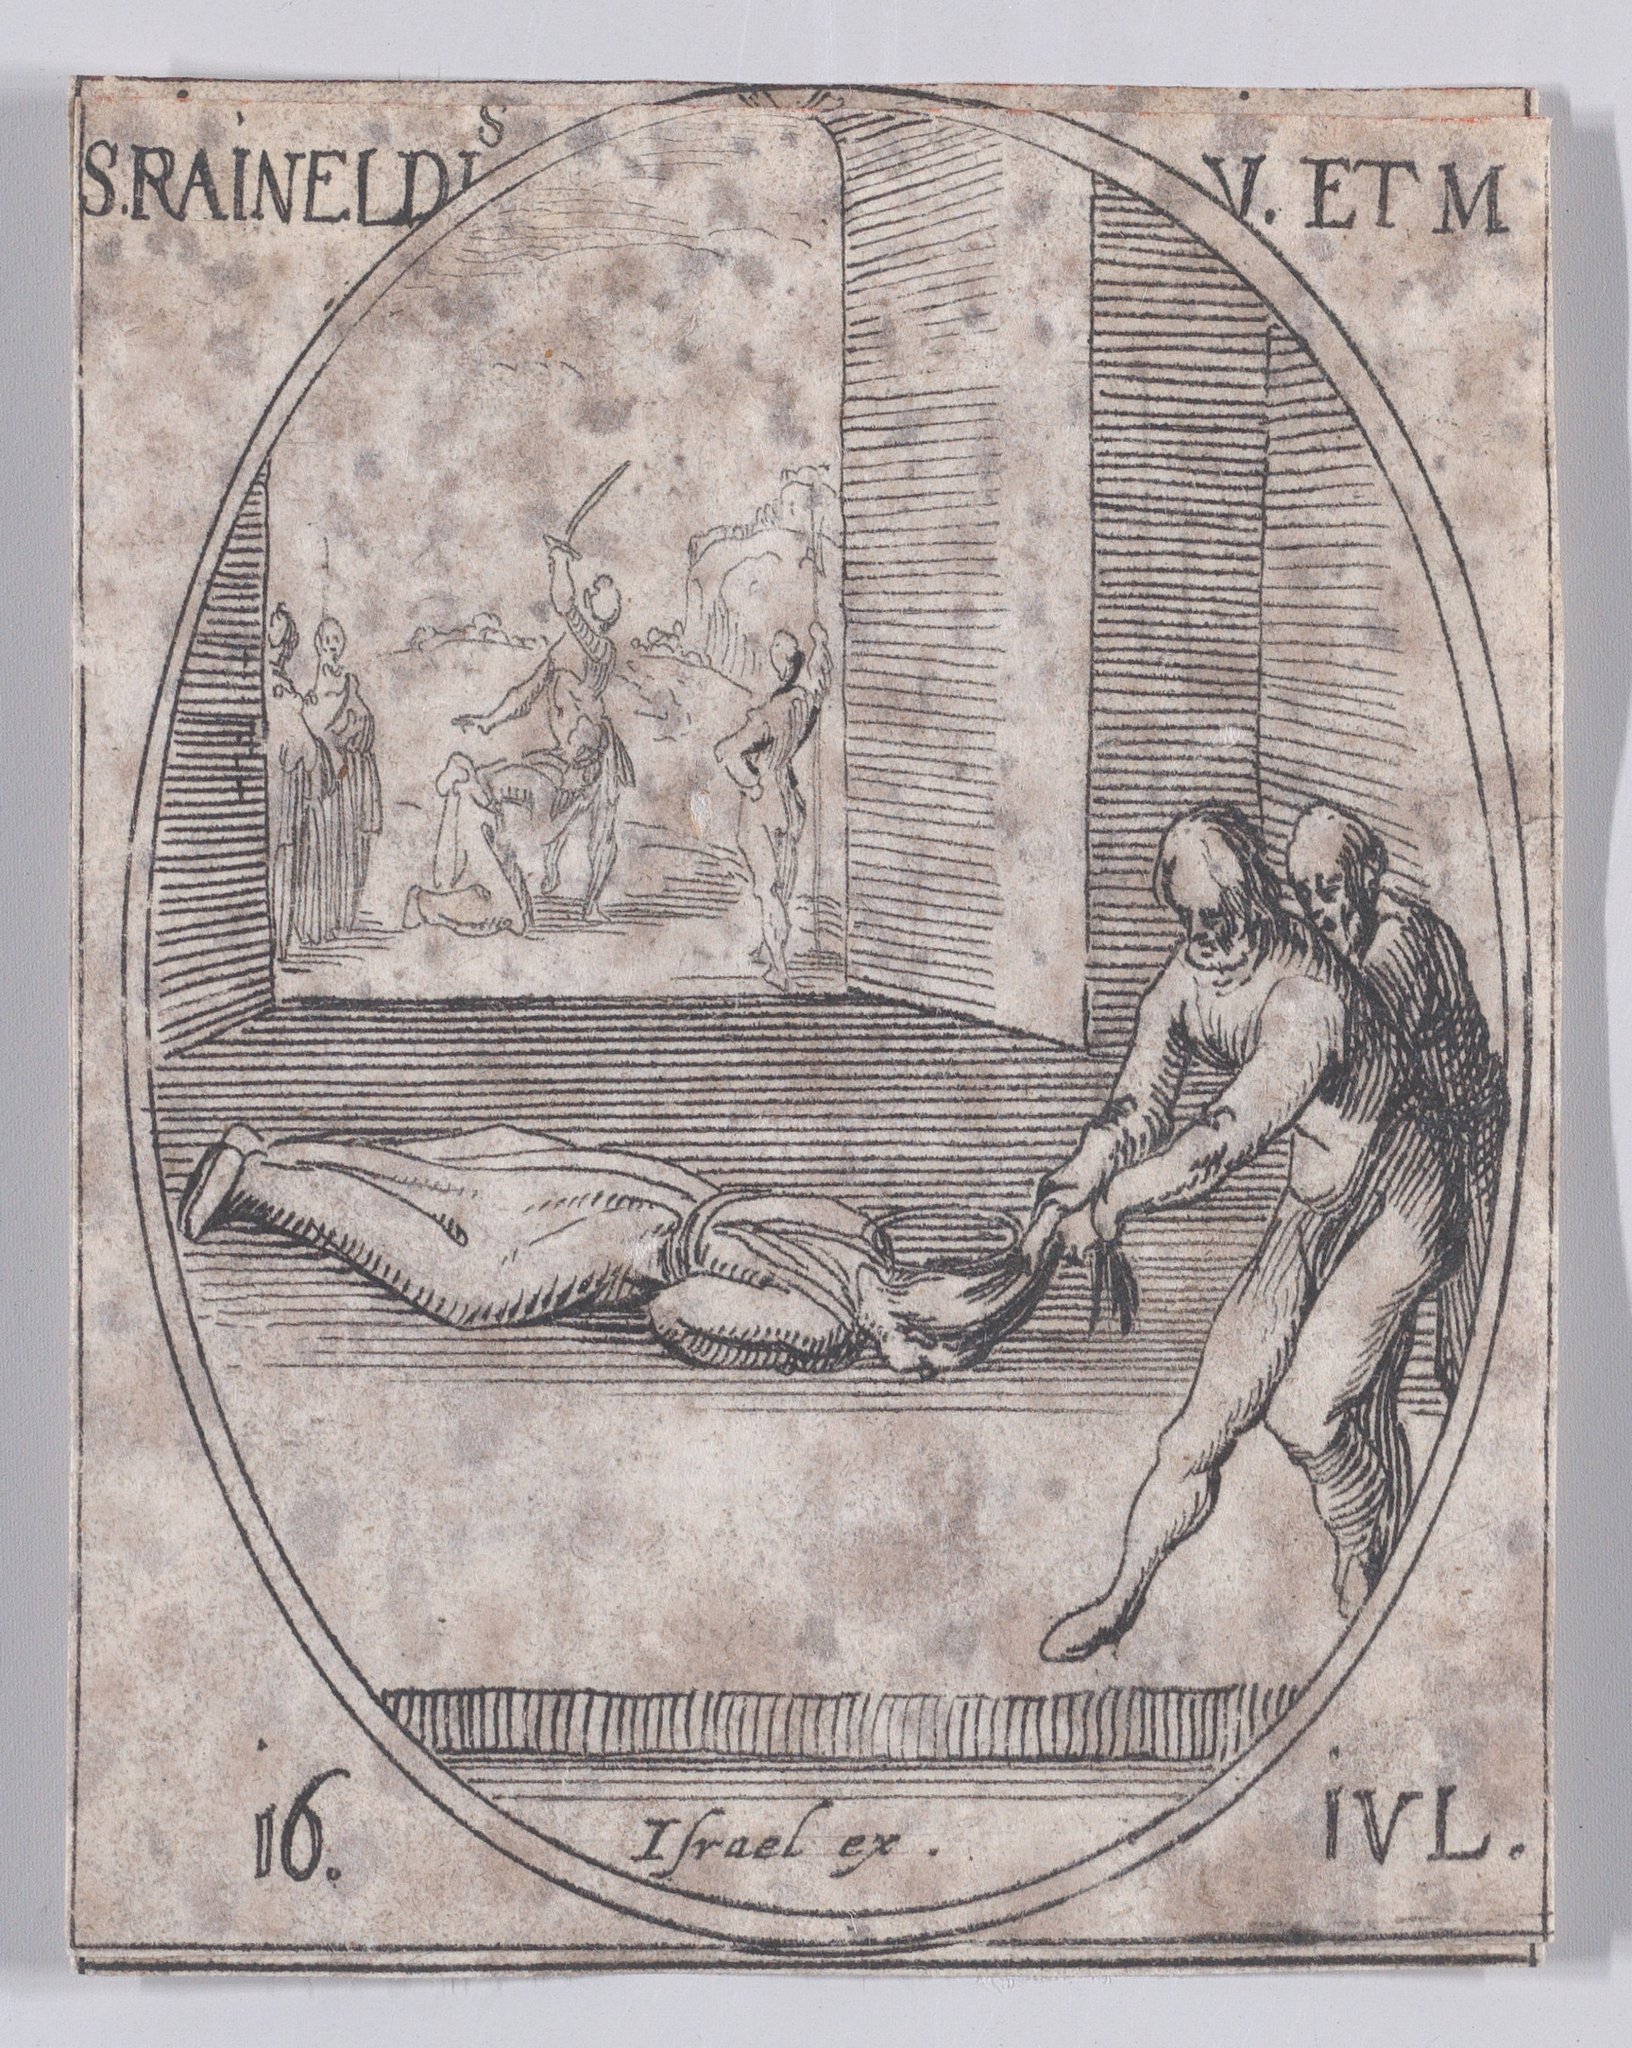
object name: print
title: Ste. Reynelde, vierge et martyre (St. Reineldis, Virgin and Martyr), July 16th, from "Les Images De Tous Les Saincts et Saintes de L'Année" (Images of All of the Saints and Religious Events of the Year)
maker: jacques callot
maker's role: artist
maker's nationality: french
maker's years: 1592-1635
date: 1636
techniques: etching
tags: men,women,saints